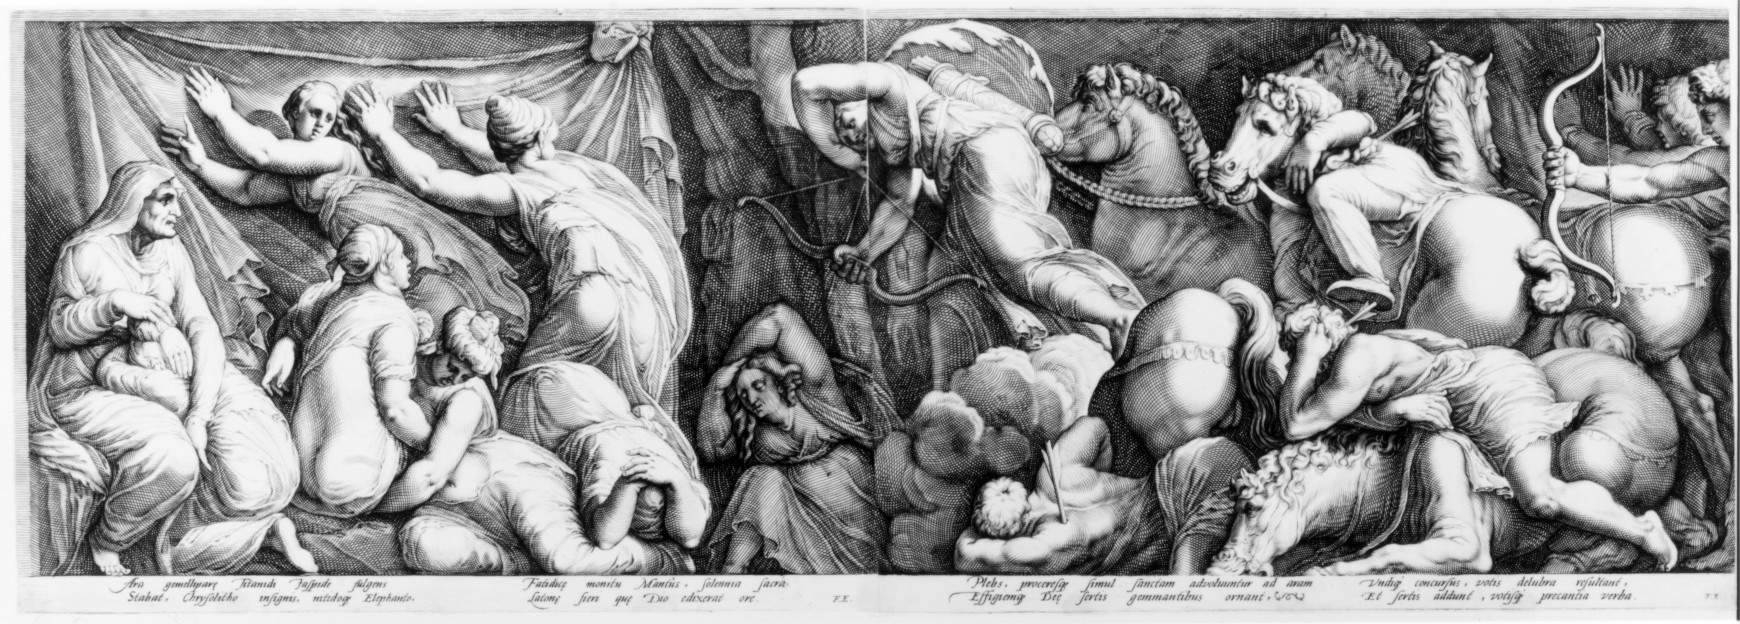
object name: print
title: The Story of Niobe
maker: jan saenredam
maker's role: artist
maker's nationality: netherlandish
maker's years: 1565-1607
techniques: engraving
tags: bow and arrow,women,horses